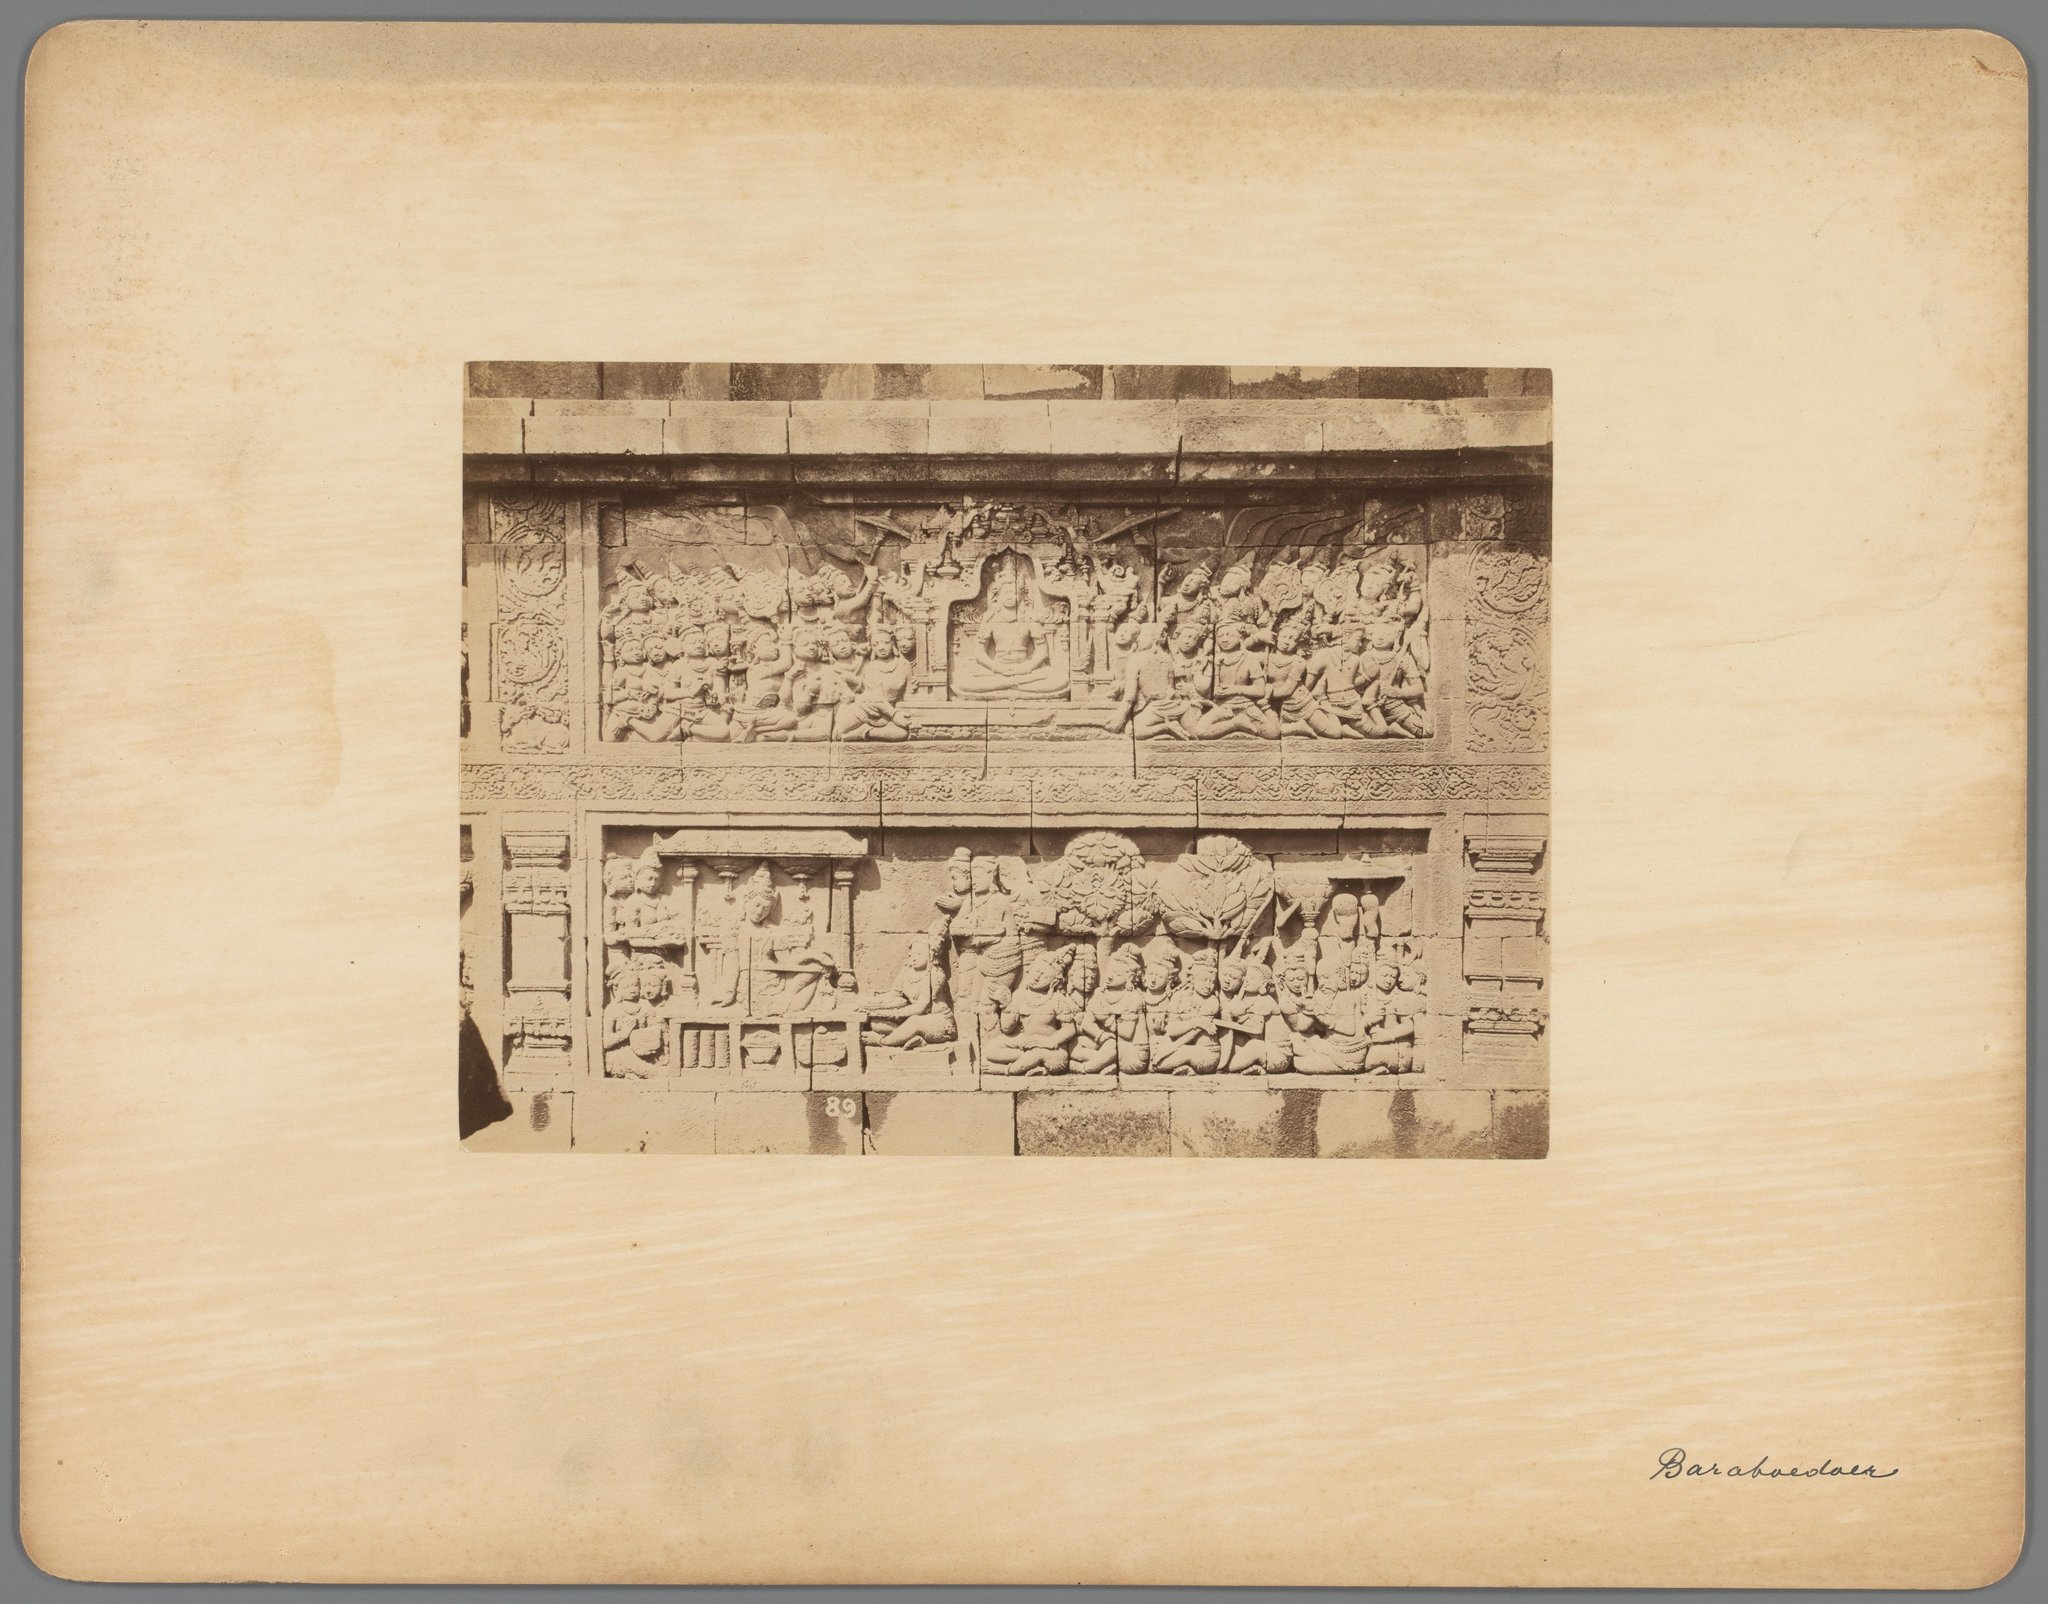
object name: photograph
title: Baraboedoer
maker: kassian céphas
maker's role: fotograaf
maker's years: 1845-1912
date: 1872-1895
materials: cardboard, paper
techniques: albumen print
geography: java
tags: piece of sculpture, reproduction of a piece of sculpture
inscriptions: inscription: ‘Foto’, number: ‘89’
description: Deze foto zat oorspronkelijk in prentenkabinet RP-F-AA3192.